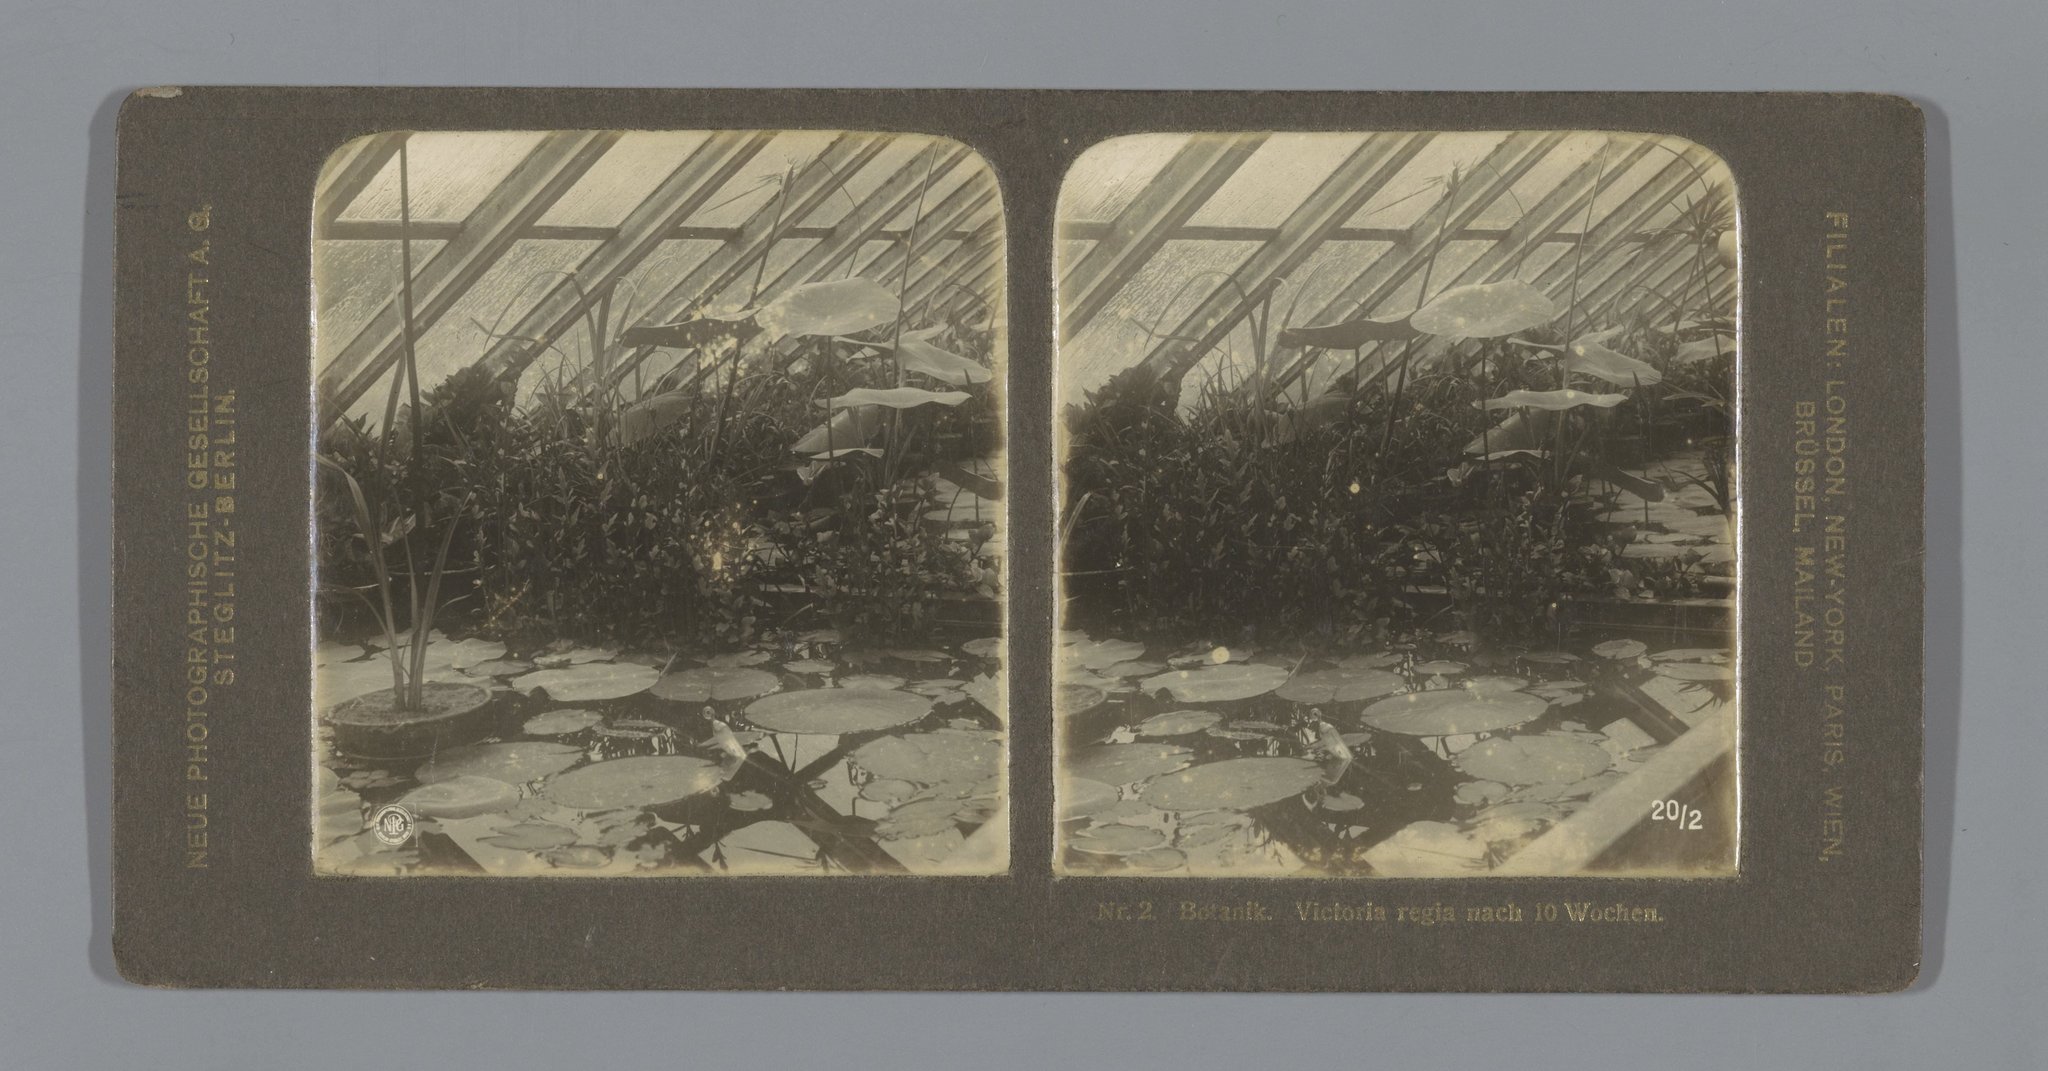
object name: stereograph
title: Nr. 2 Botanik. Victoria regia nach 10 Wochen.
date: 1900-1920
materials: cardboard, photographic support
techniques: gelatin silver print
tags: flowers: water-lily, botanic garden, 'hortus botanicus'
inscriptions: monogram: ‘NPG’, : ‘Steglitz-Berlin’, number: ‘20/2’, : ‘Filialen: London, New-York, Paris, Wien, Brüssel, Mailand’